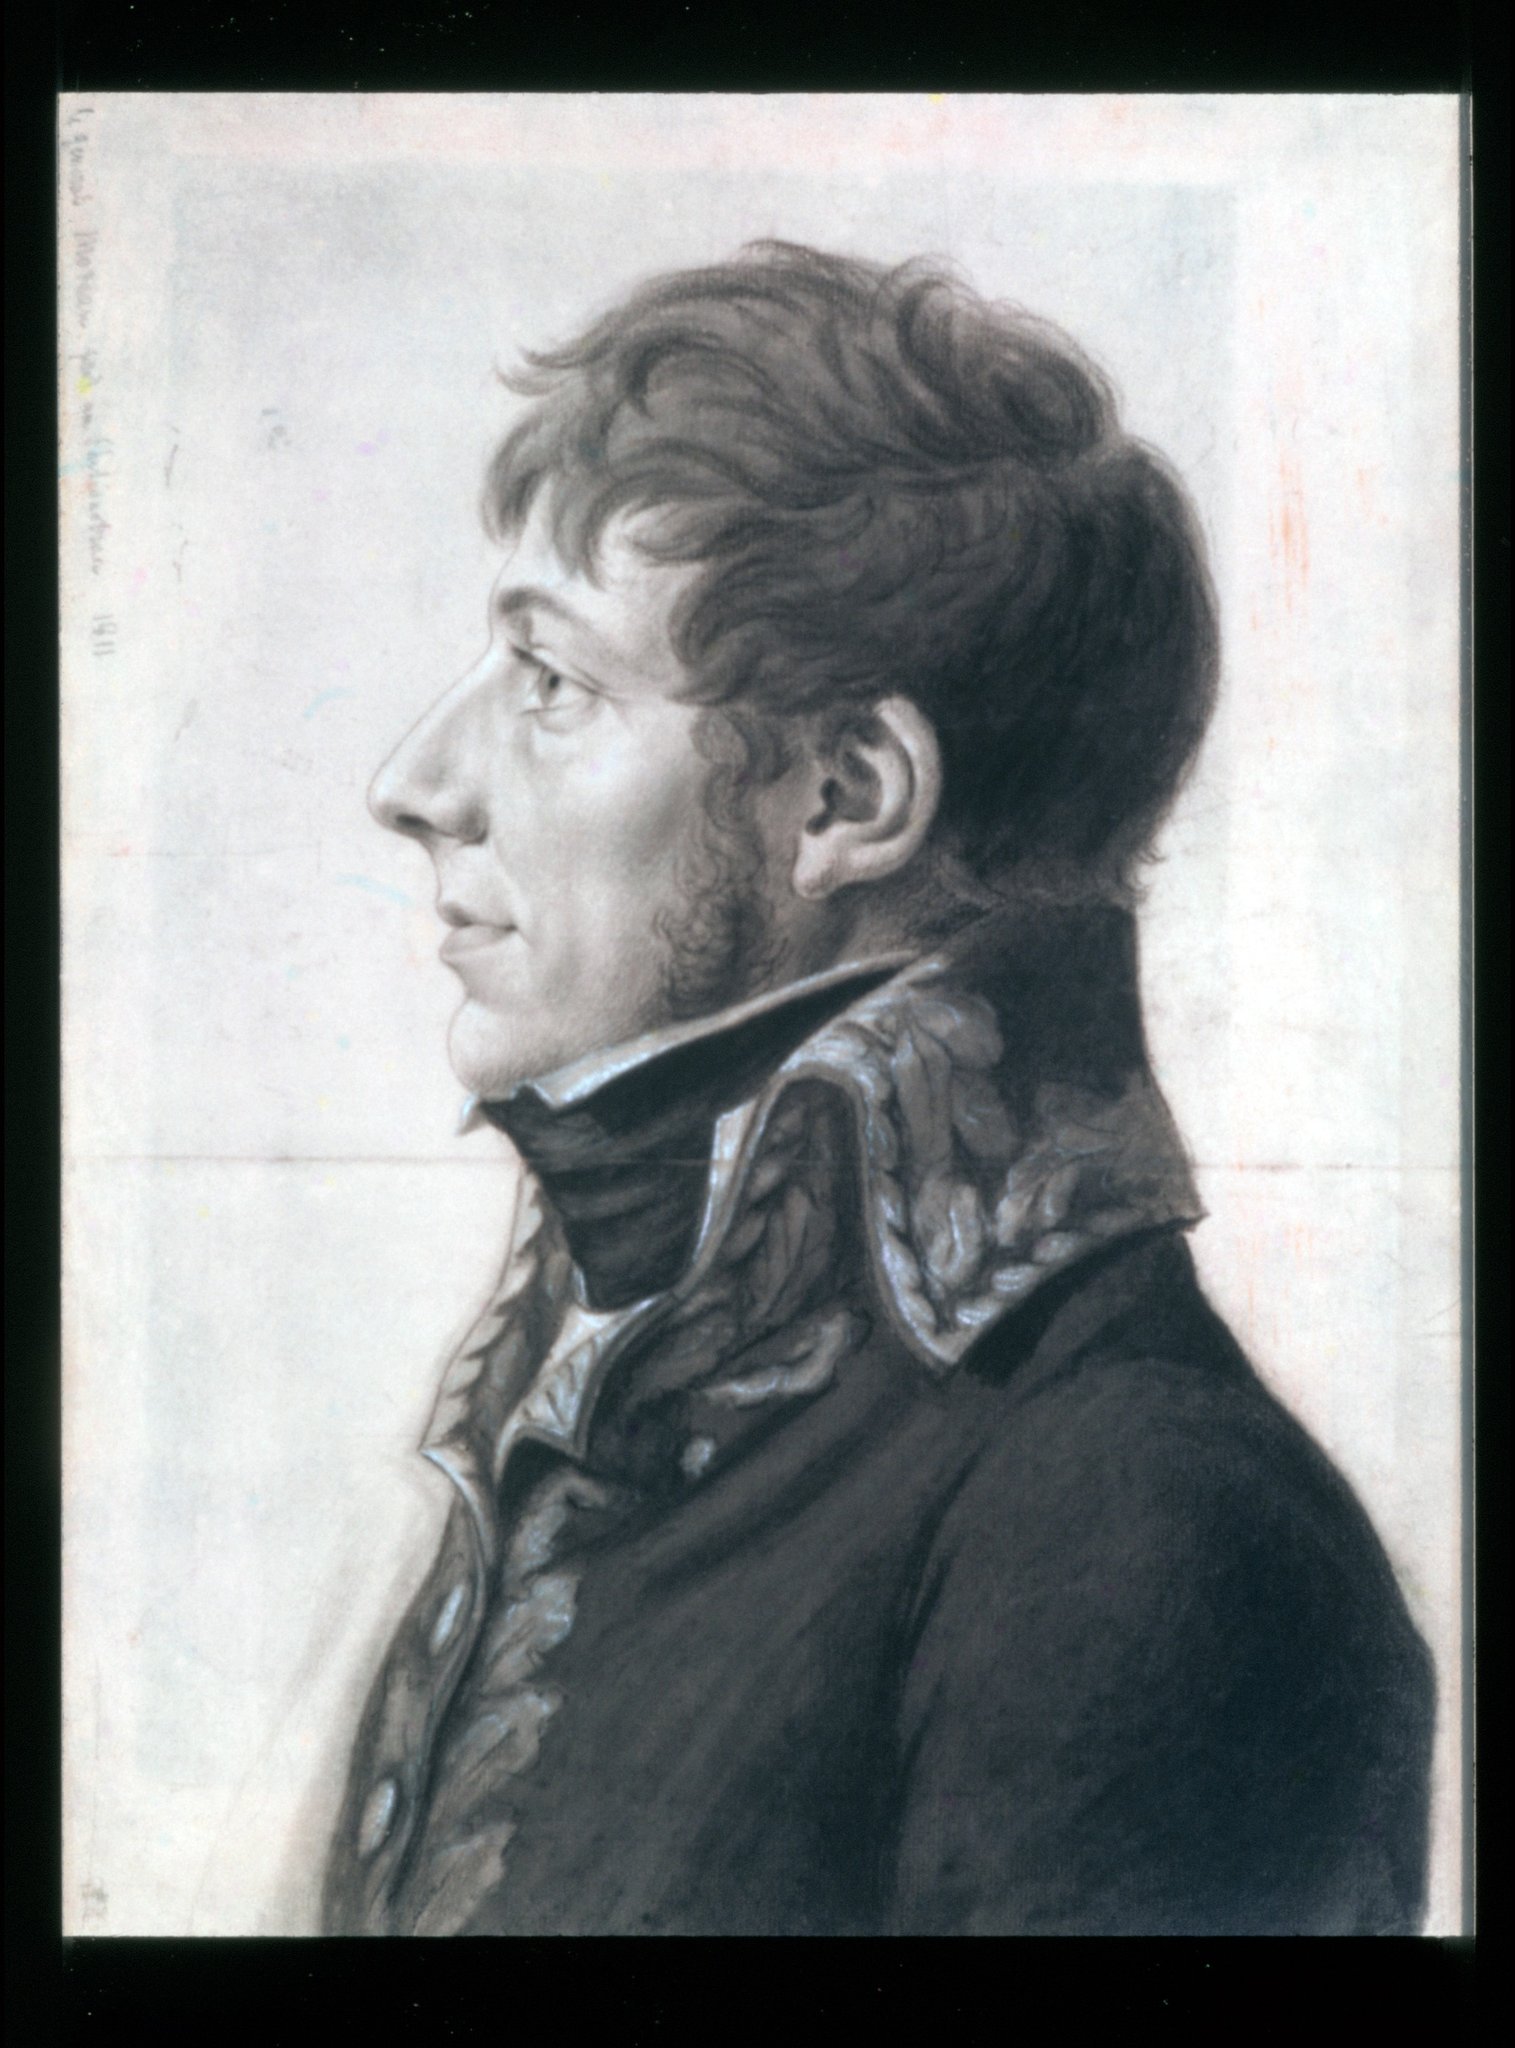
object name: drawing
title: Jean-Victor Moreau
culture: american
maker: charles balthazar julien févret de saint-mémin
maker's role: artist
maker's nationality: french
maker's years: 1770-1852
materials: chalk, charcoal, crayon, gouache, paper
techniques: heightening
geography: france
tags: men,portraits,profiles